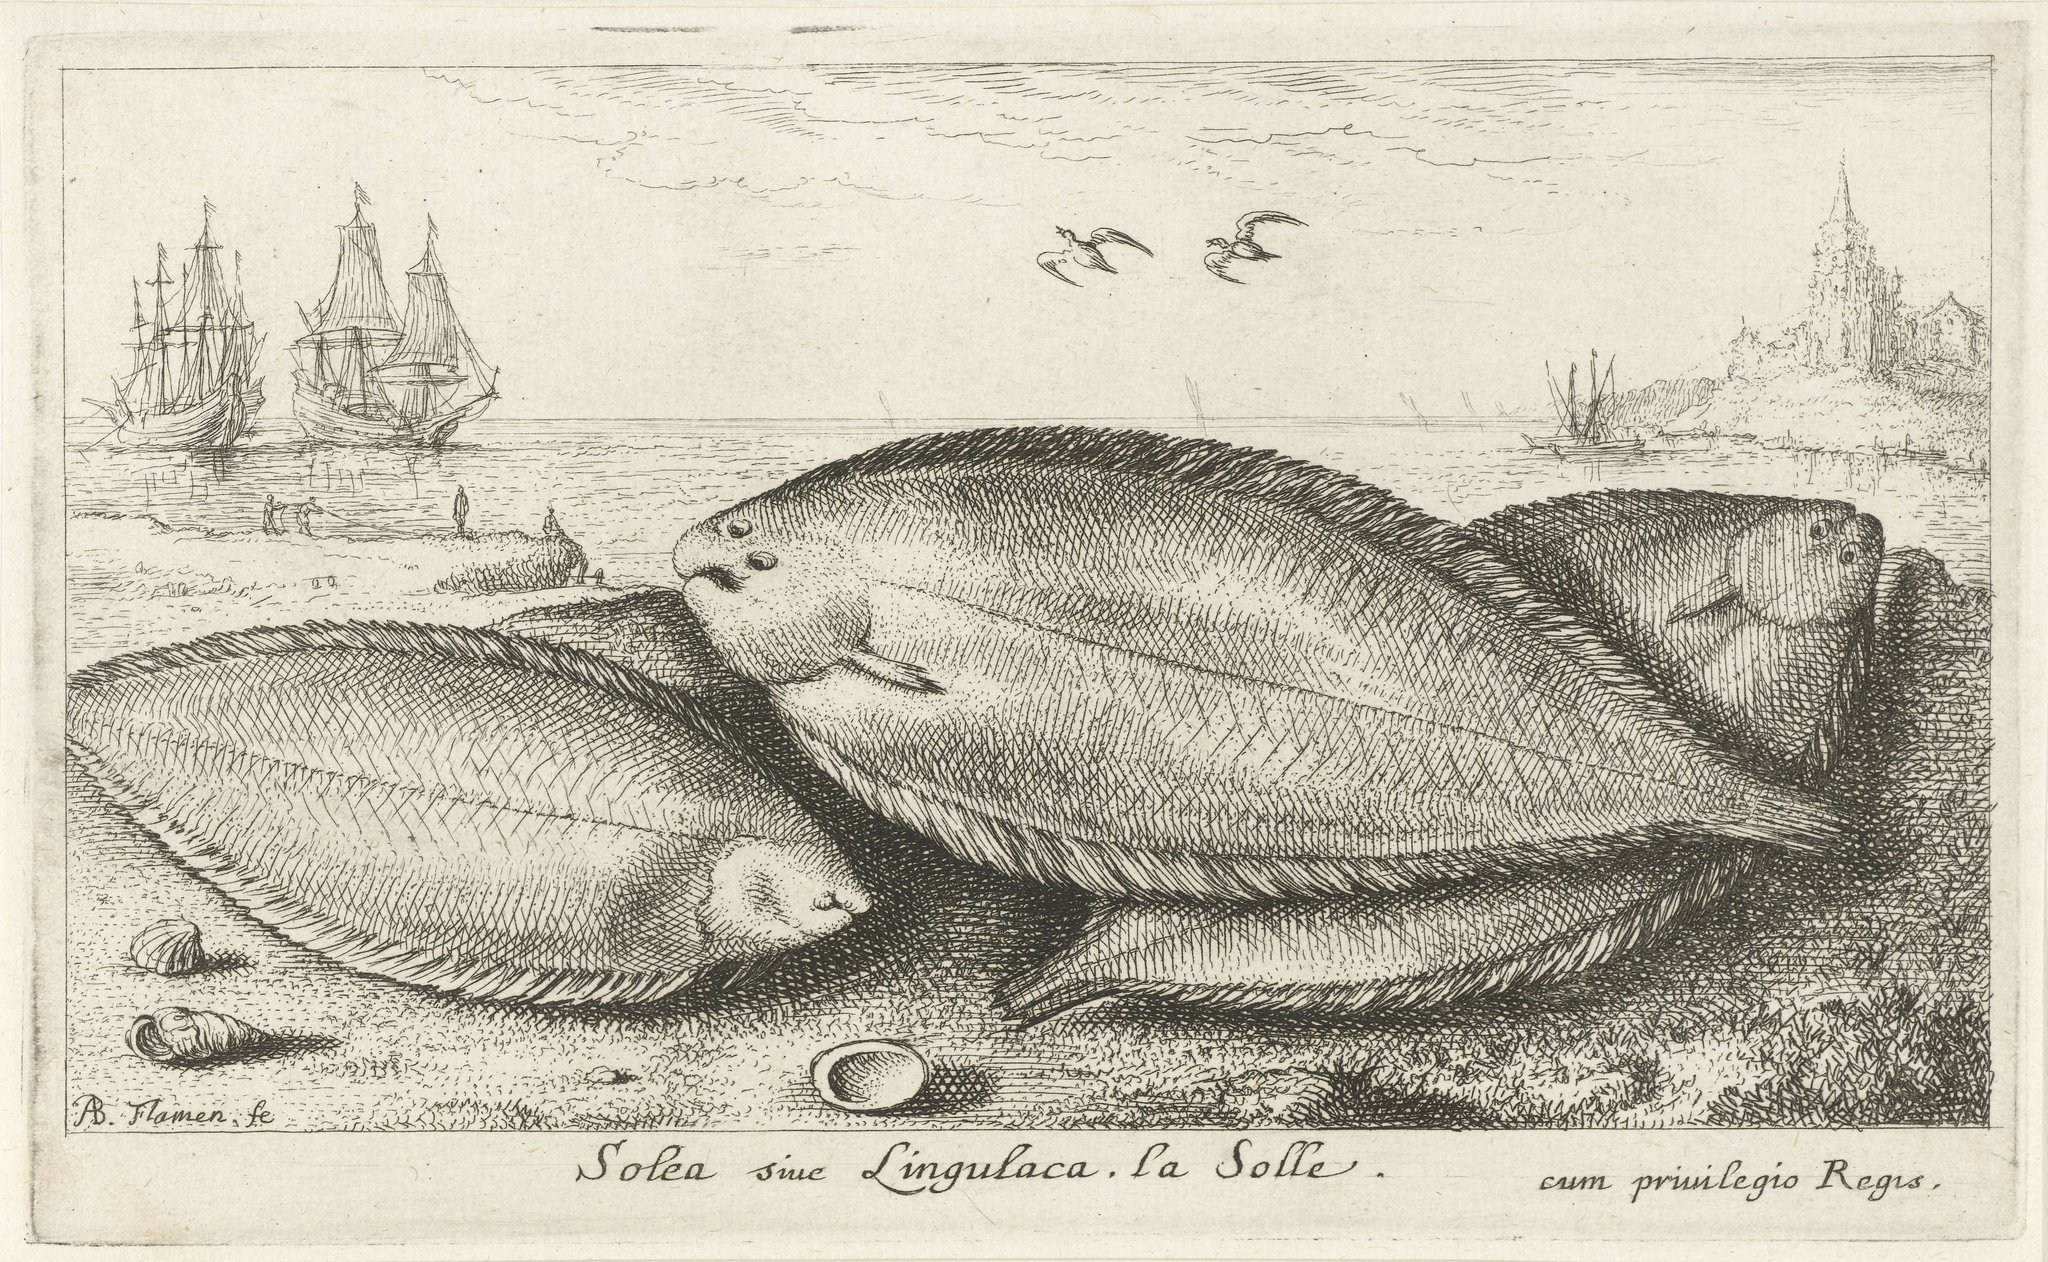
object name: print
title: Drie zeetongen op het strand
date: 1664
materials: paper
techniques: etching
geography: france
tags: fishes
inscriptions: collector's mark: Lugt 2228